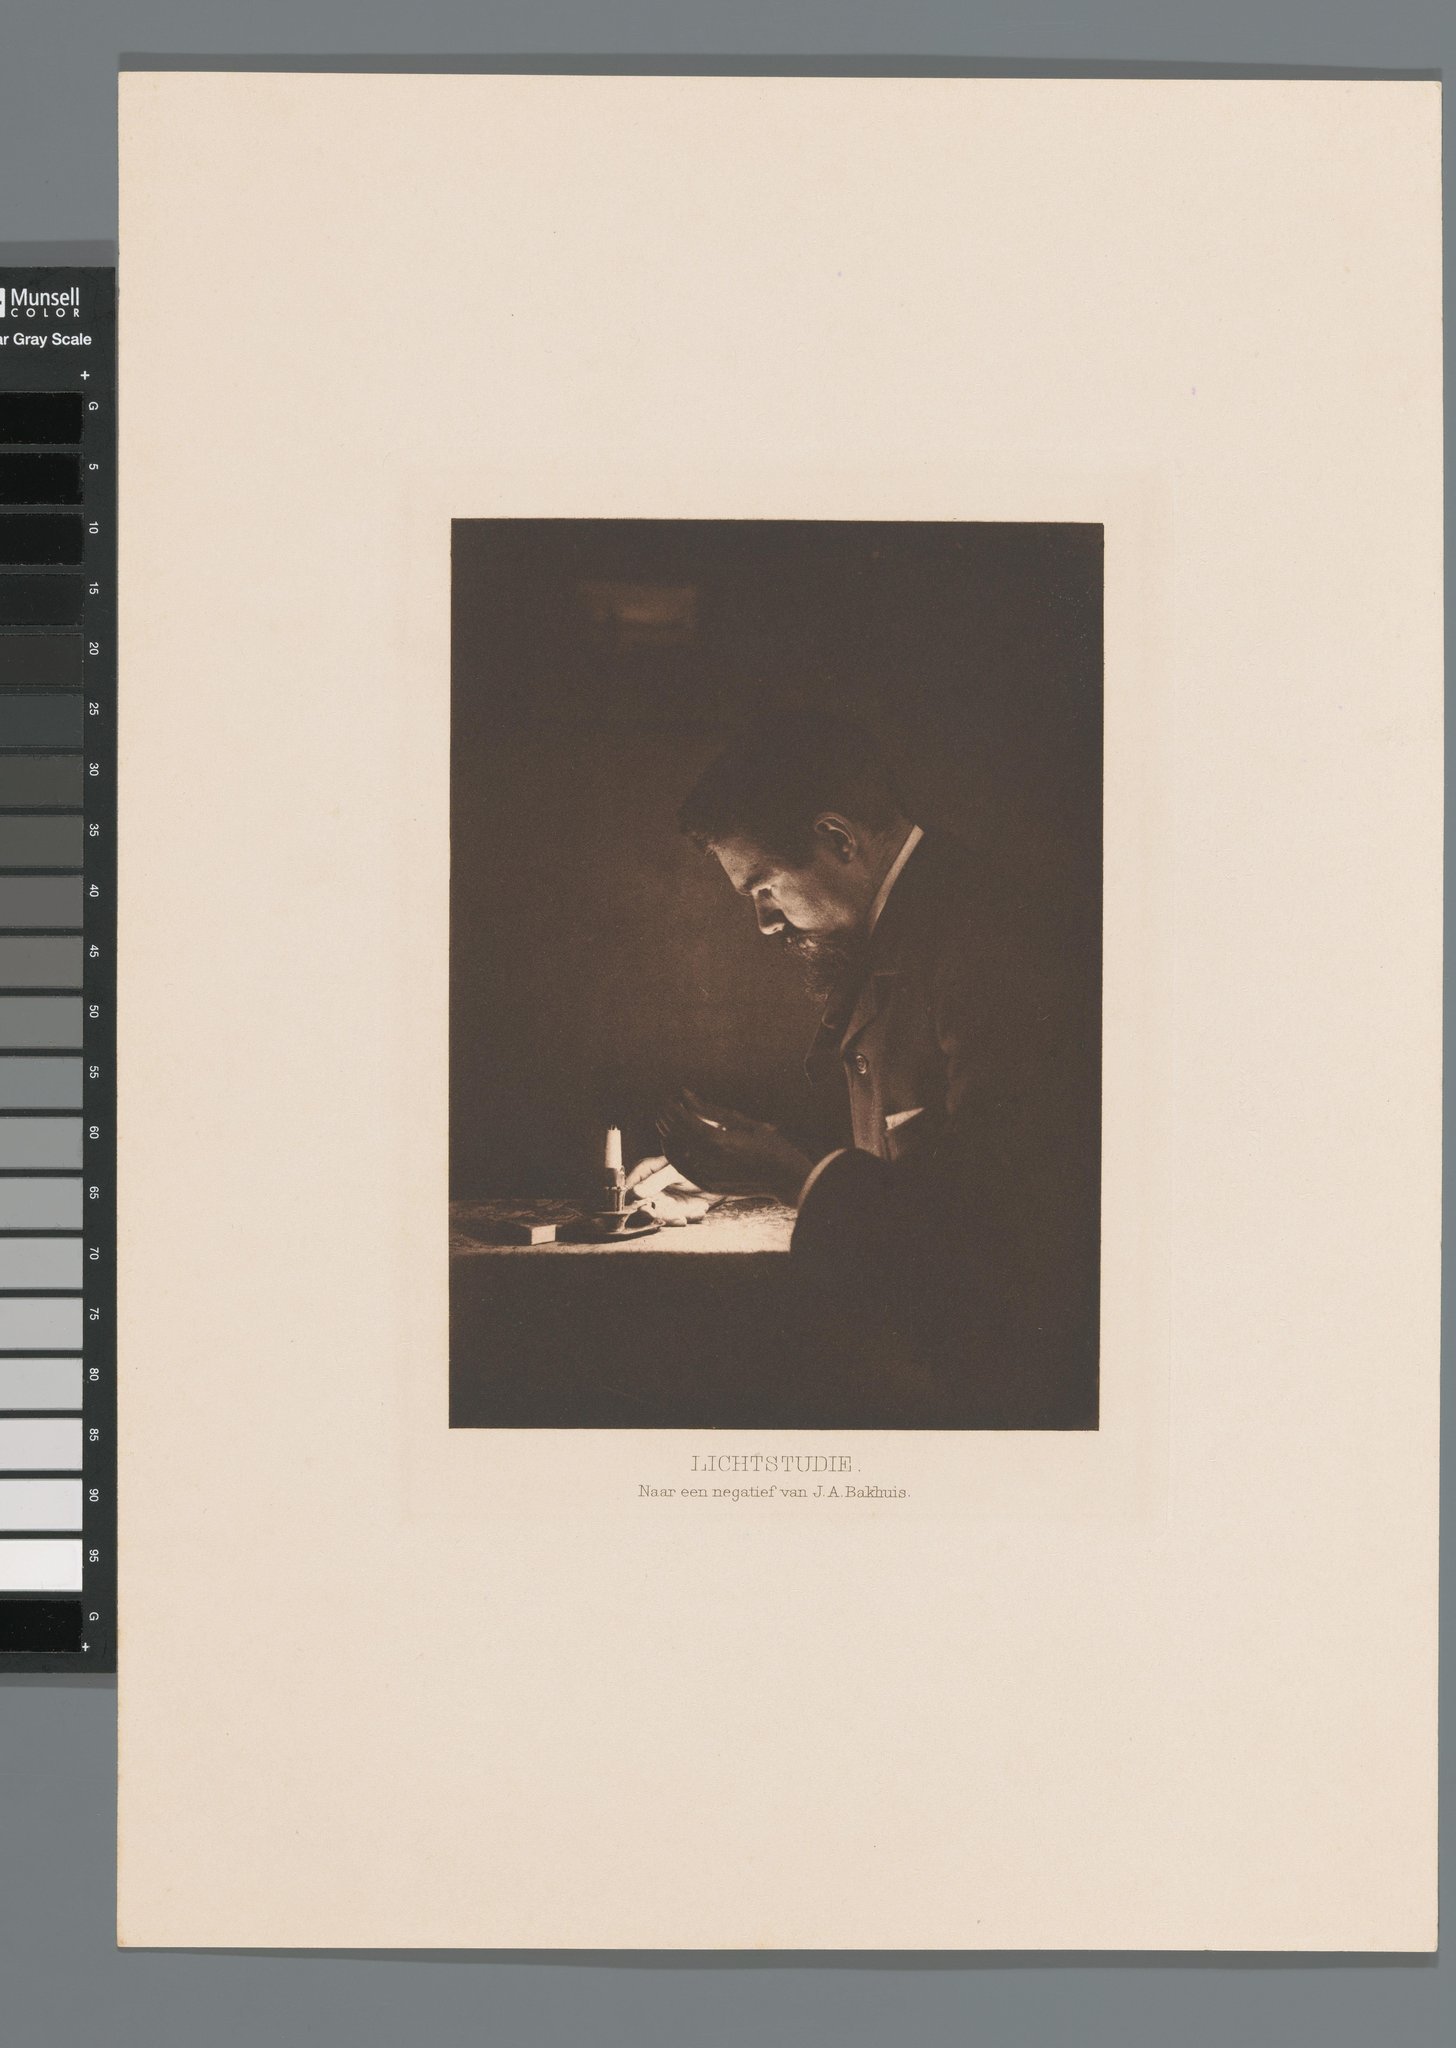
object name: photomechanical print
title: Lichtstudie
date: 1901-1906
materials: paper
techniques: photoaquatint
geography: netherlands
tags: adult man, candle